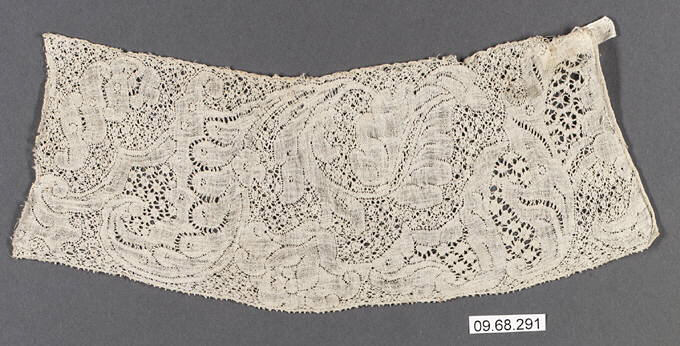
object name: fragment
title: Fragment of lace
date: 1601-1800